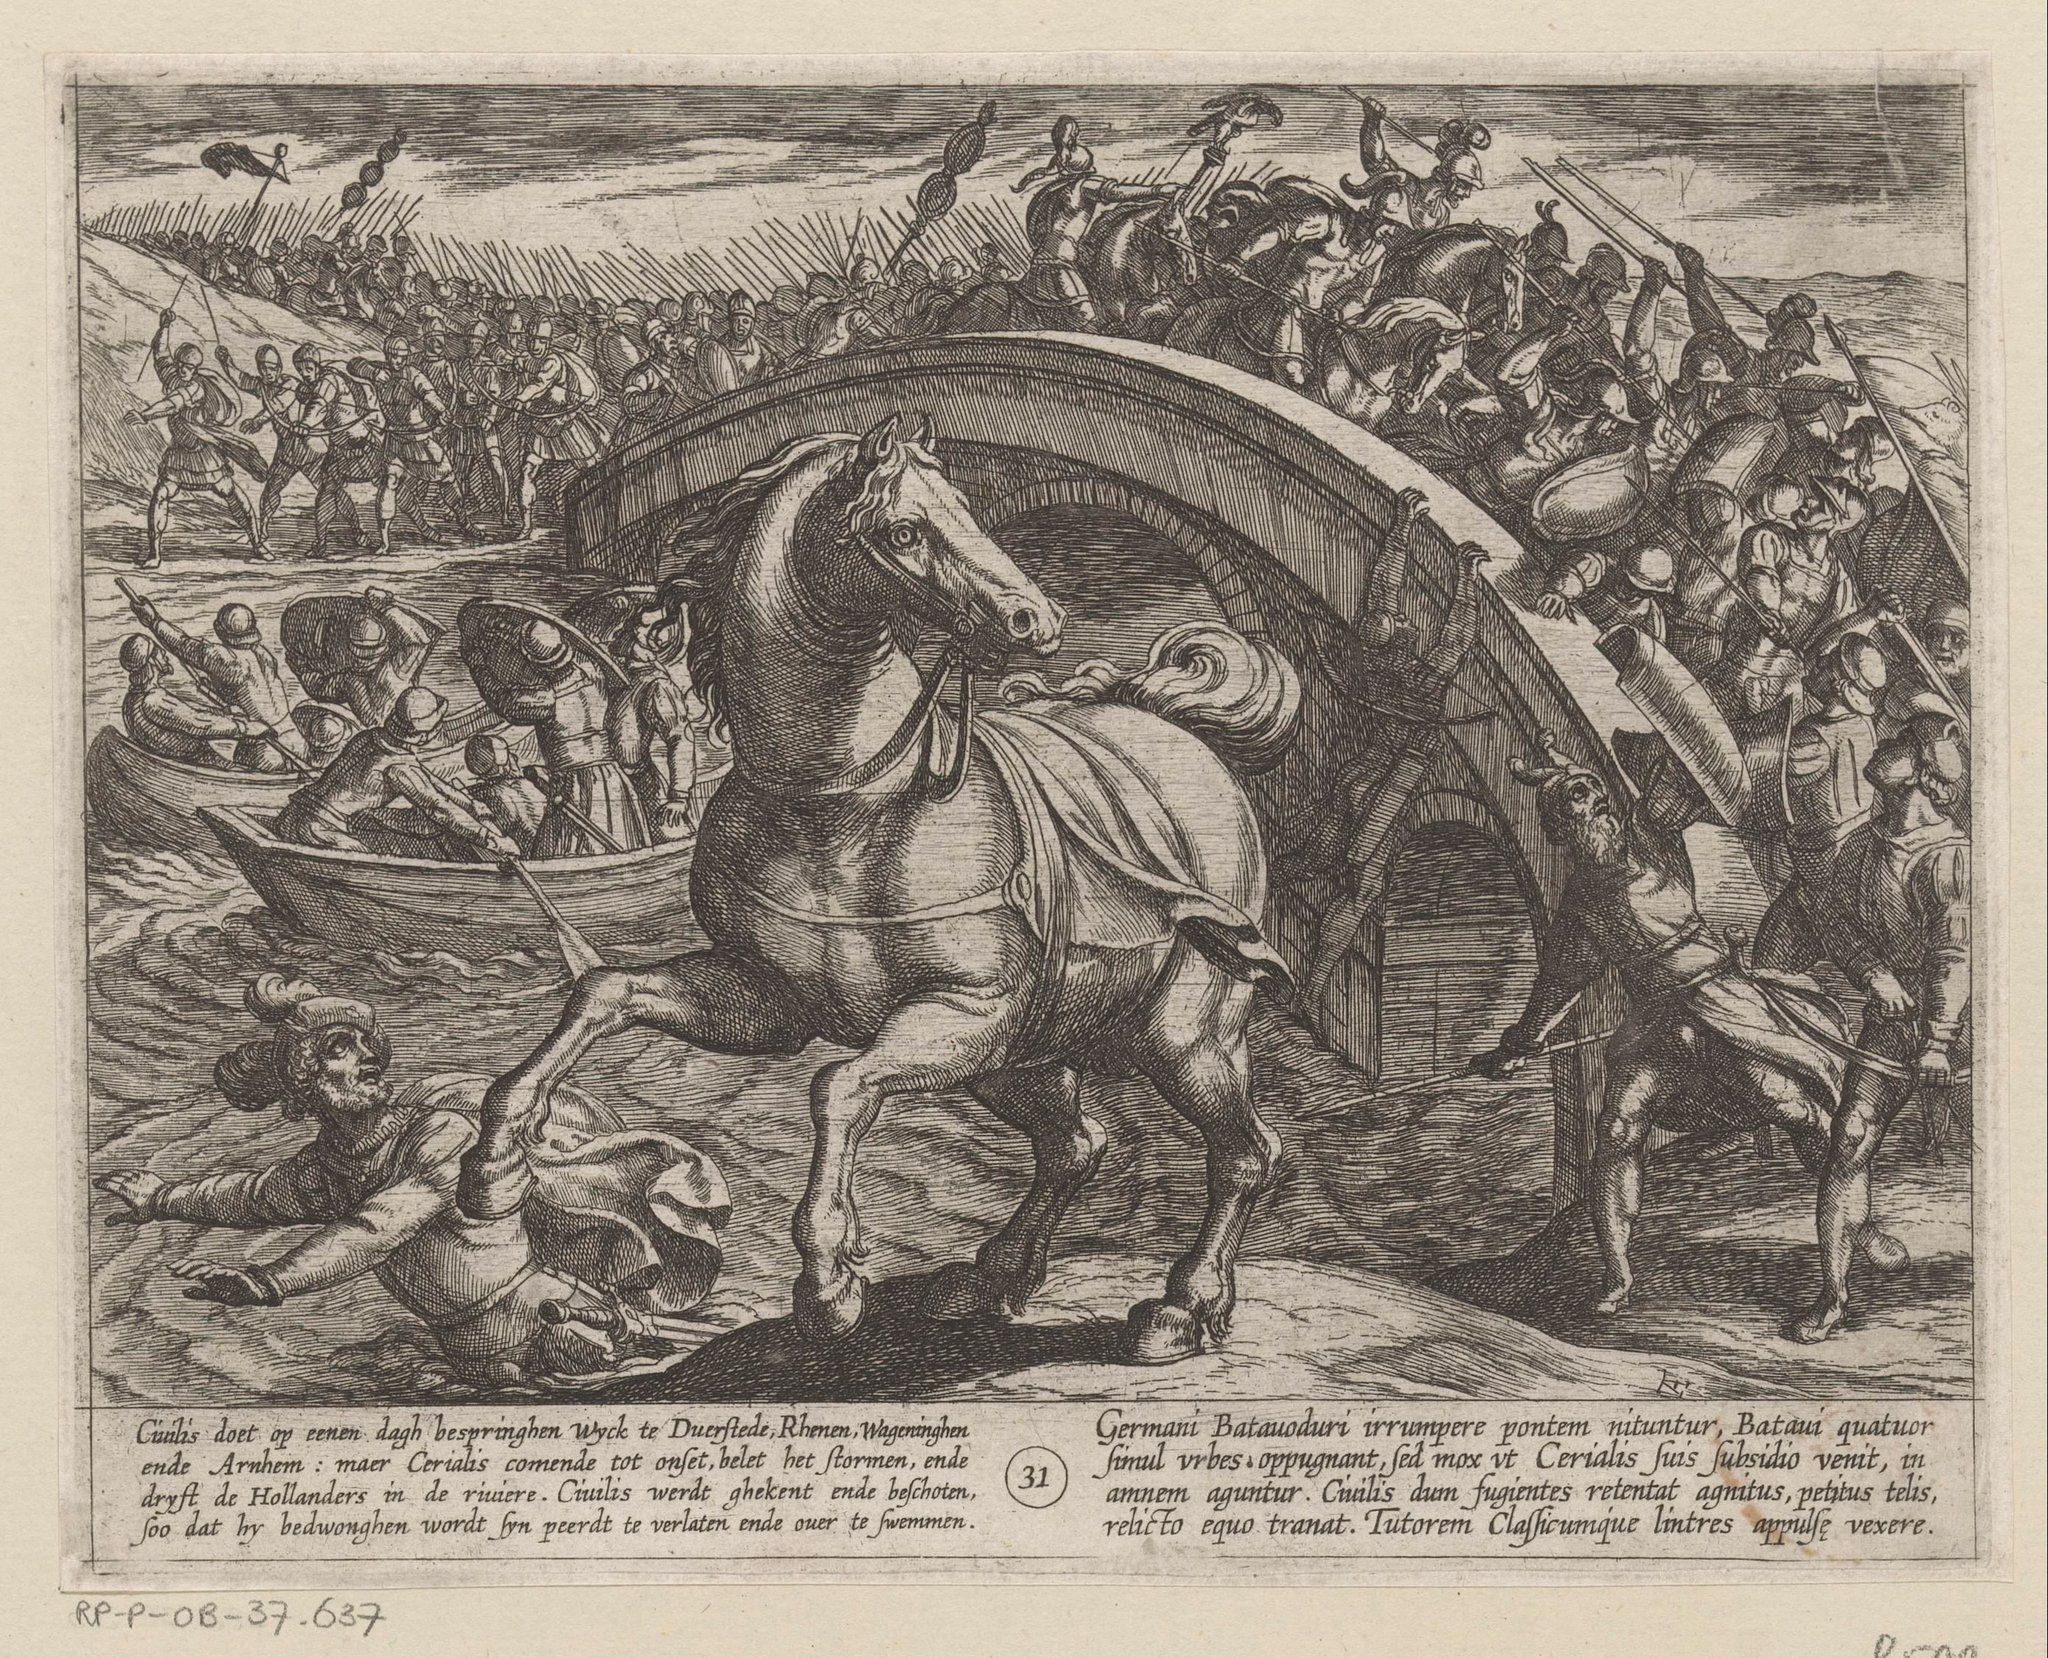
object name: print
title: Batavorum cum Romanis Bellum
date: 1611-1612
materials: paper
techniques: etching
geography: southern netherlands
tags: battle, the soldier; the soldier's life, retreat of the defeated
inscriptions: collector's mark: Lugt 240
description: Julius Civilis wordt in de strijd tegen de Romeinen gedwongen af te stijgen van zijn paard en zwemmend de rivier over te steken. Het leger van Civilis moet ook terugtrekken. Onderschrift in het Nederlands en in het Latijn.